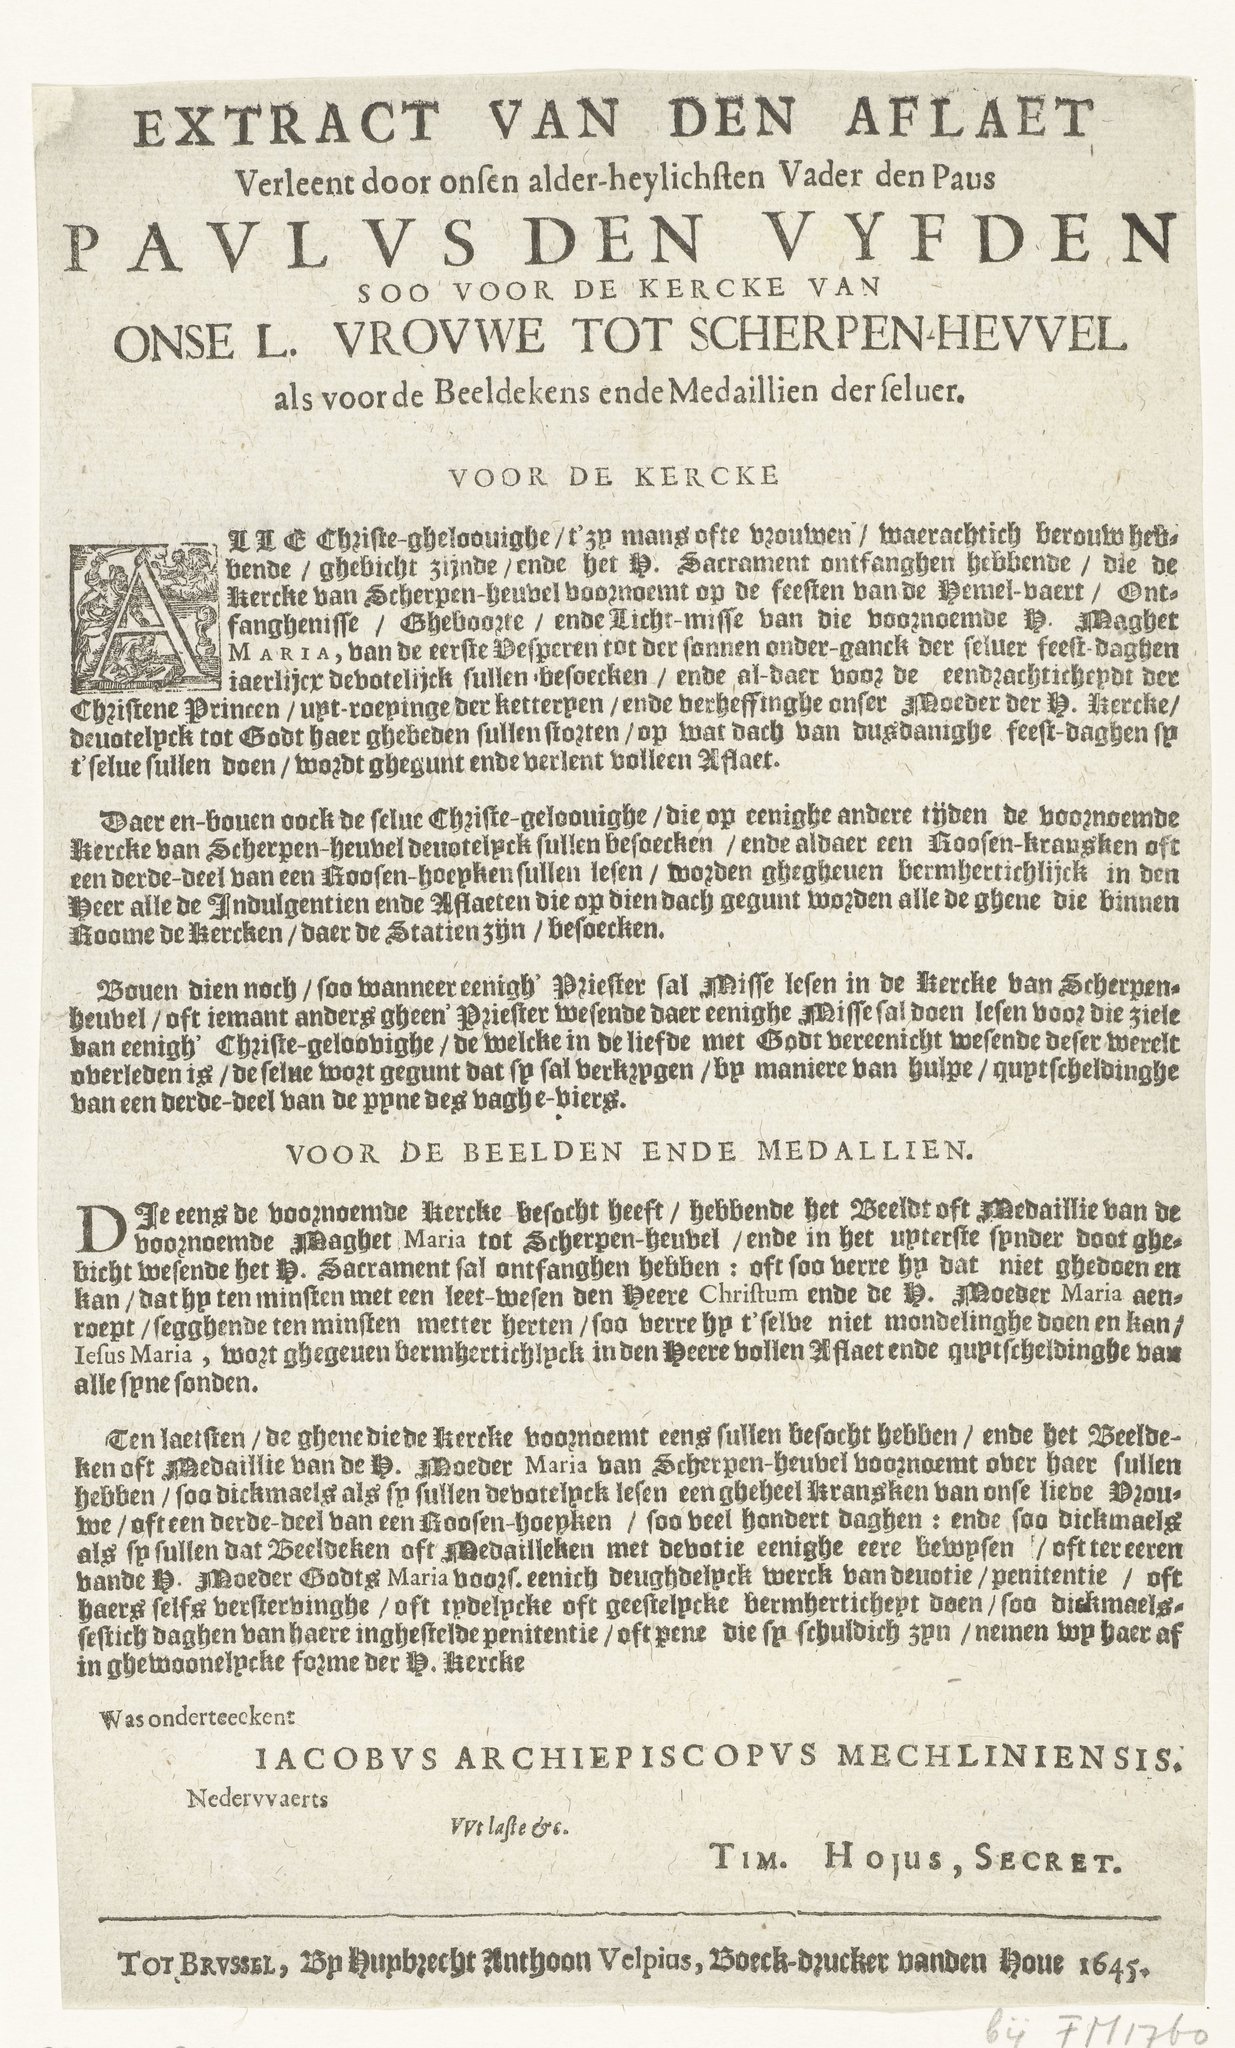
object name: text sheet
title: Extract van de aflaat voor de kerk van Scherpenheuvel, 1645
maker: hubert anthoine velpius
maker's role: printer, publisher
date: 1645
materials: paper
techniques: letterpress printing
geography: brussels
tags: paulus v, scherpenheuvel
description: Extract van de aflaat van paus Paulus V voor de Onze-Lieve-Vrouwebasiliek van Scherpenheuvel en de beelden en medailles die daar verkocht worden, 1645. Tekst in het Nederlands ondertekend door de aartsbisschop van Mechelen.